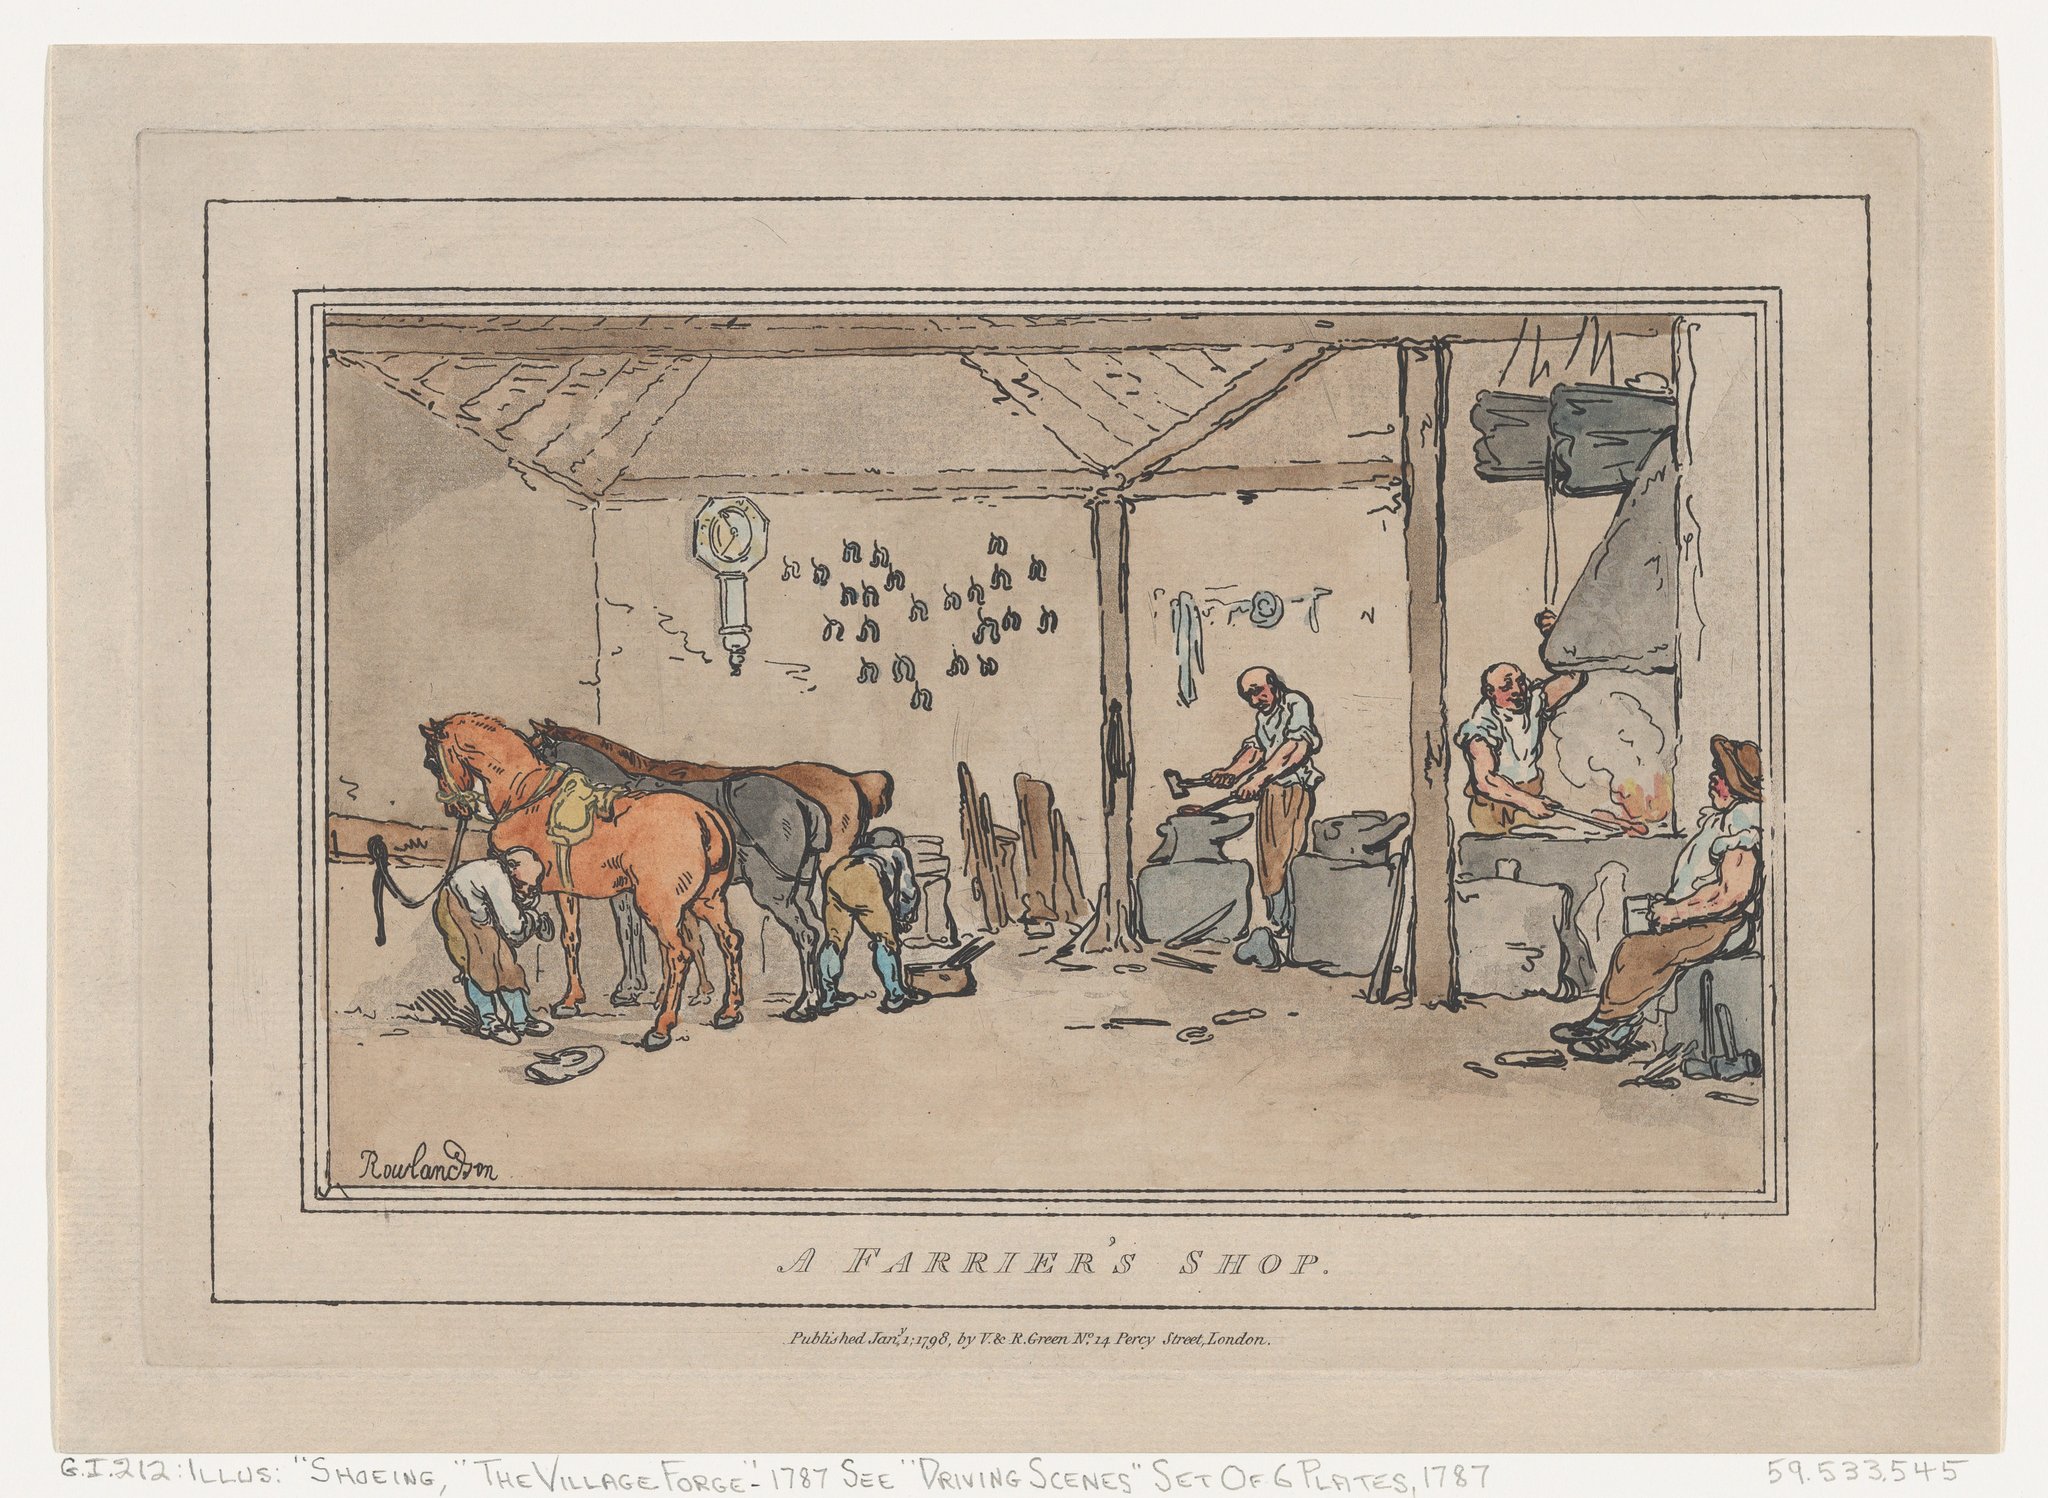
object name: print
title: A Farrier's Shop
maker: thomas rowlandson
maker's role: artist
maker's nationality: british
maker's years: 1757-1827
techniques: aquatint, etching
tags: men,horses,markets